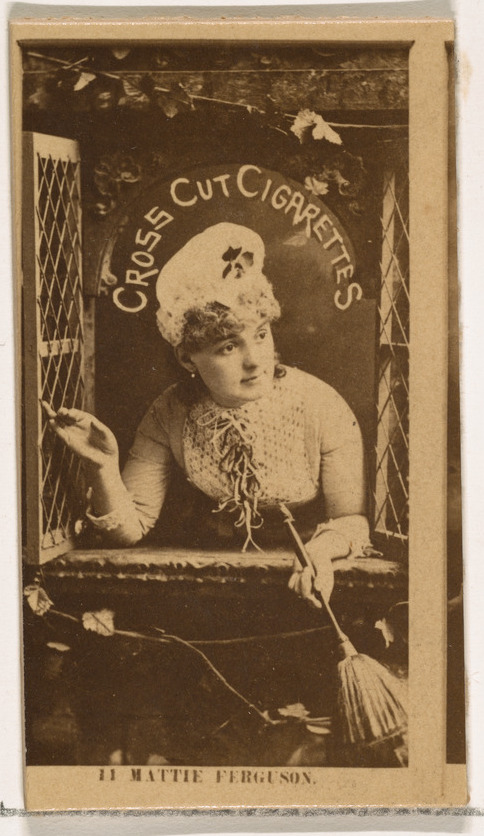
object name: print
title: Card Number 11, Mattie Ferguson, from the Actors and Actresses series (N145-2) issued by Duke Sons & Co. to promote Cross Cut Cigarettes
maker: w. duke, sons & co.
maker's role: publisher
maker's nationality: american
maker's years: 1870-1920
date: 1880-1889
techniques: albumen silver print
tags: portraits,women,actresses